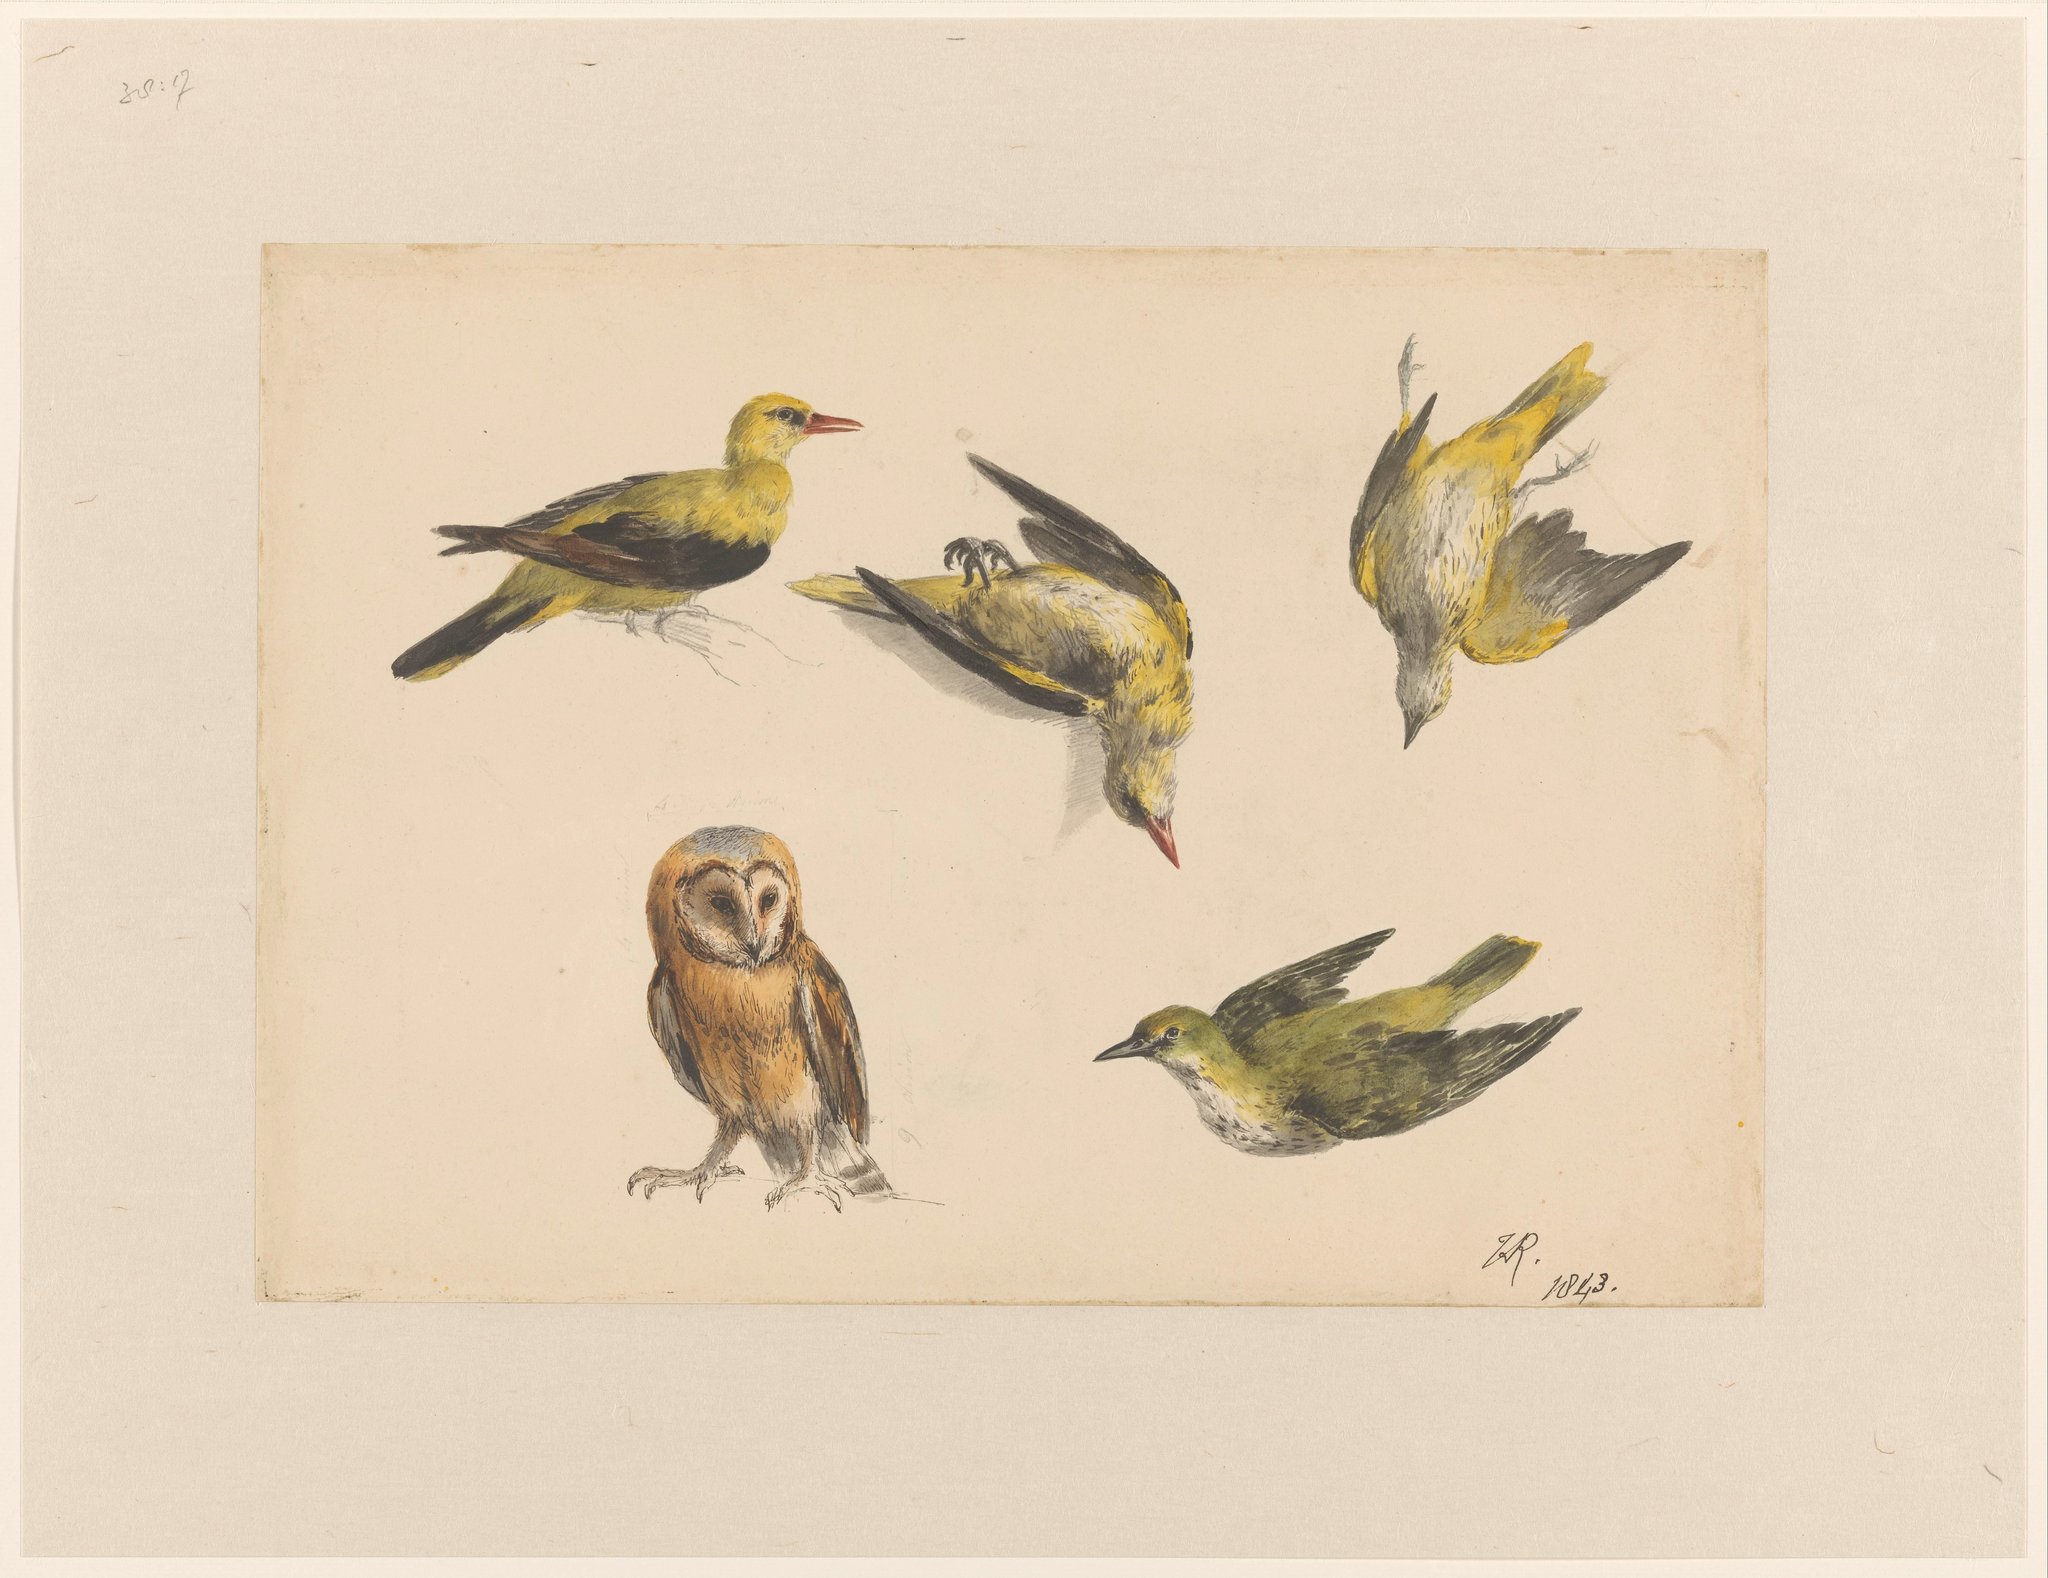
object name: drawing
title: Studies van een uil en twee wielewalen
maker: henriëtte ronner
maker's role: draughtsman, painter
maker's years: 1821-1909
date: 1843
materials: ink, paper, pencil, watercolor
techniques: brush, pen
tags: owls: barn owl, song-birds (golden oriole)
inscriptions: date: ‘1843’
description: Studies van een kerkuil (Tyto alba) en vier wielewalen (Oriolus oriolus), twee mannetjes en twee vrouwtjes.